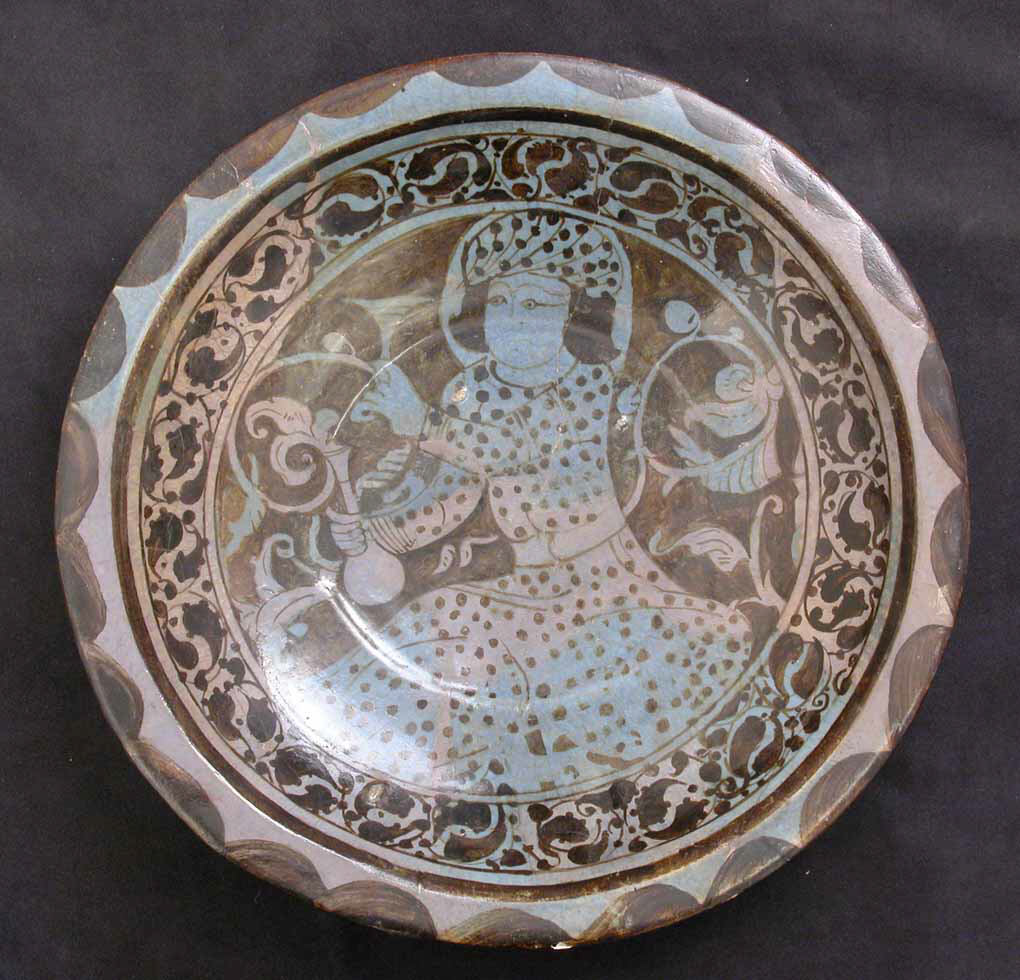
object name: dish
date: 1101-1300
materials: stonepaste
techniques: luster painting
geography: iran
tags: men